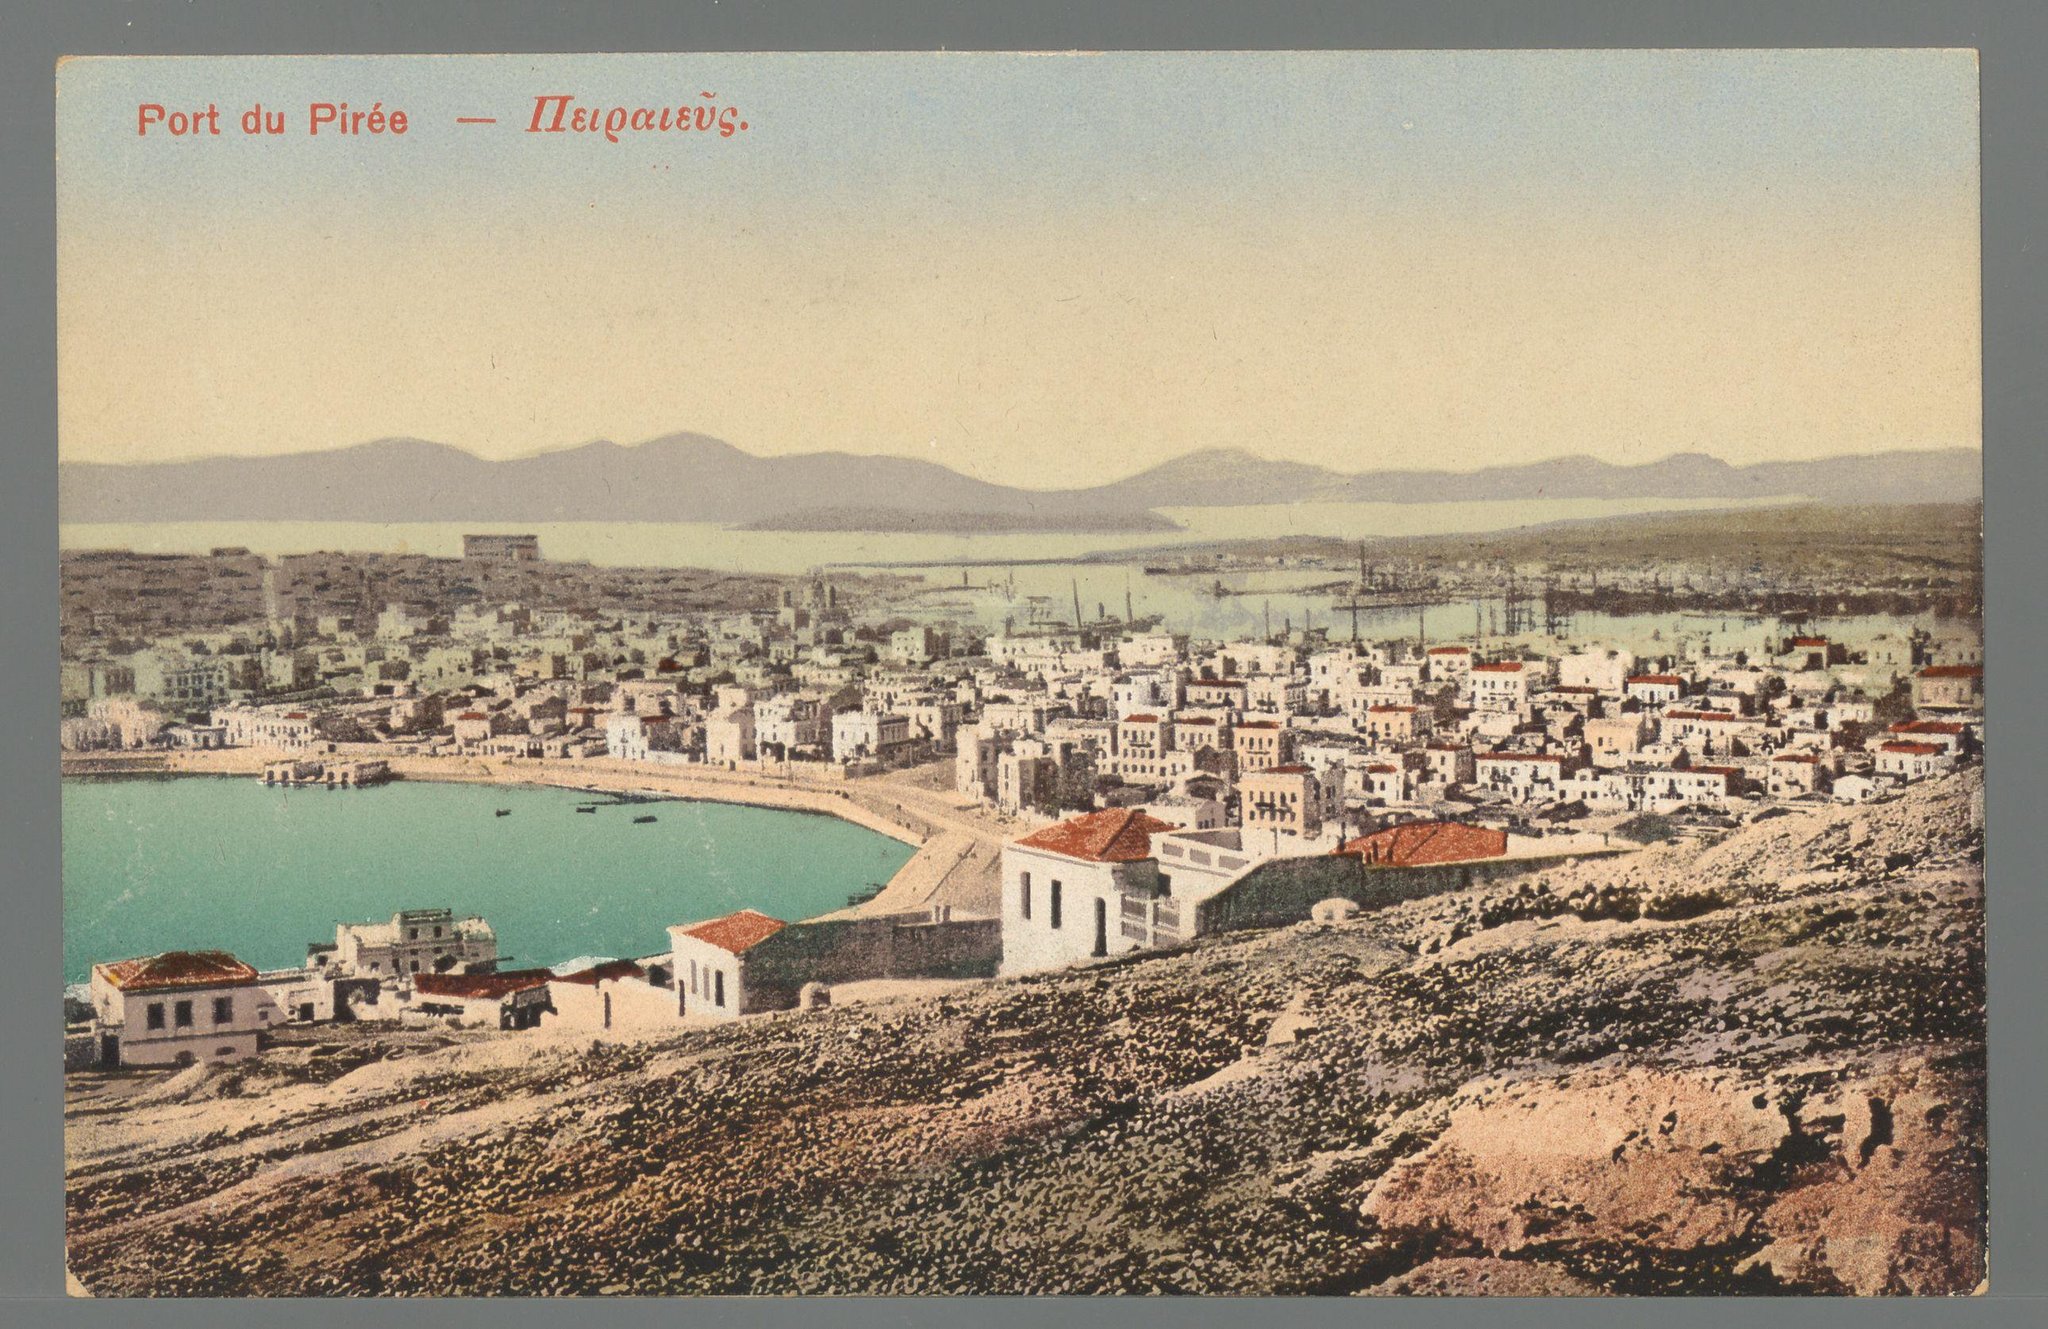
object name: photomechanical print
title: Port du Pirée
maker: Anonymous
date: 1906-1930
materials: cardboard, photographic process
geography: athens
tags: harbour, city-view, and landscape with man-made constructions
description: Achter de Franse titel staat de titel in het Grieks.